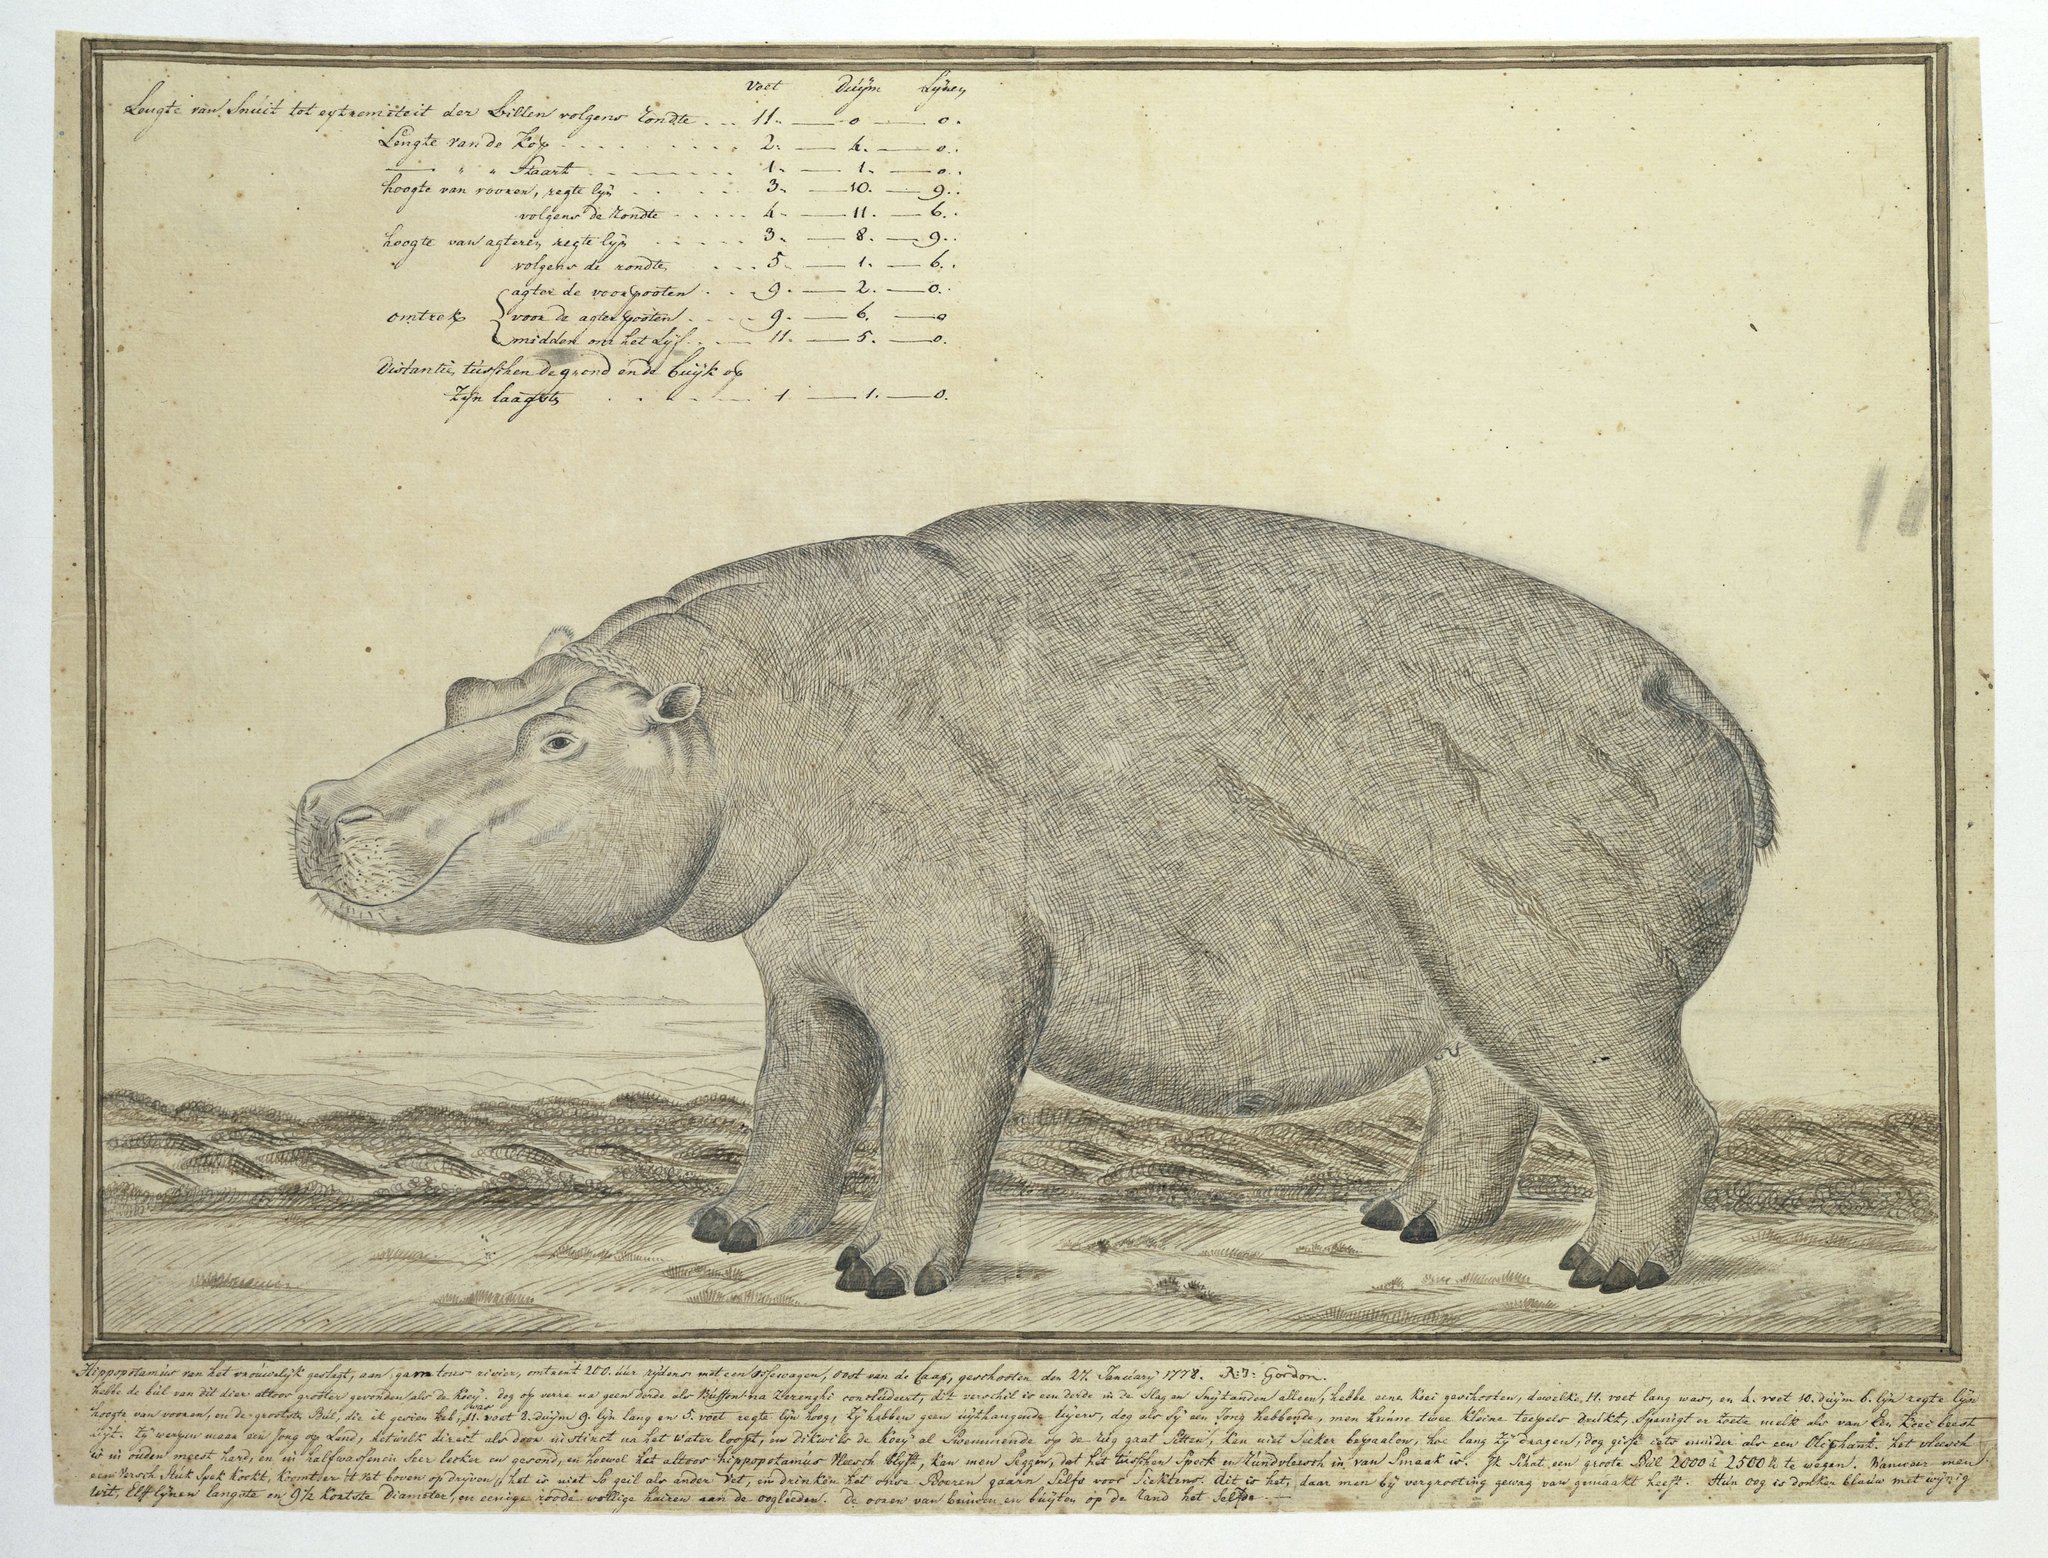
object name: drawing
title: Hippopotamus amphibius capensis (Hippopotamus; female)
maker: robert jacob gordon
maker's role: draughtsman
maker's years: 1743-1795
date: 1778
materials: chalk, ink, paper, pencil, watercolor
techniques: brush, pen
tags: hoofed animals: hippopotamus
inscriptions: annotation: ‘onderaan: Hippopotamus van het vrouwelijk geslagt, aan gamtous rivier, oost van de Caap, geschooten den 27 [...] / [...]’, signature and date: ‘[...] den 27 Januarij 1778. R:J: Gordon. /’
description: Een nijlpaard (Hippopotamus amphibius), aan de Kaap zeekoei genoemd: het vrouwtje.